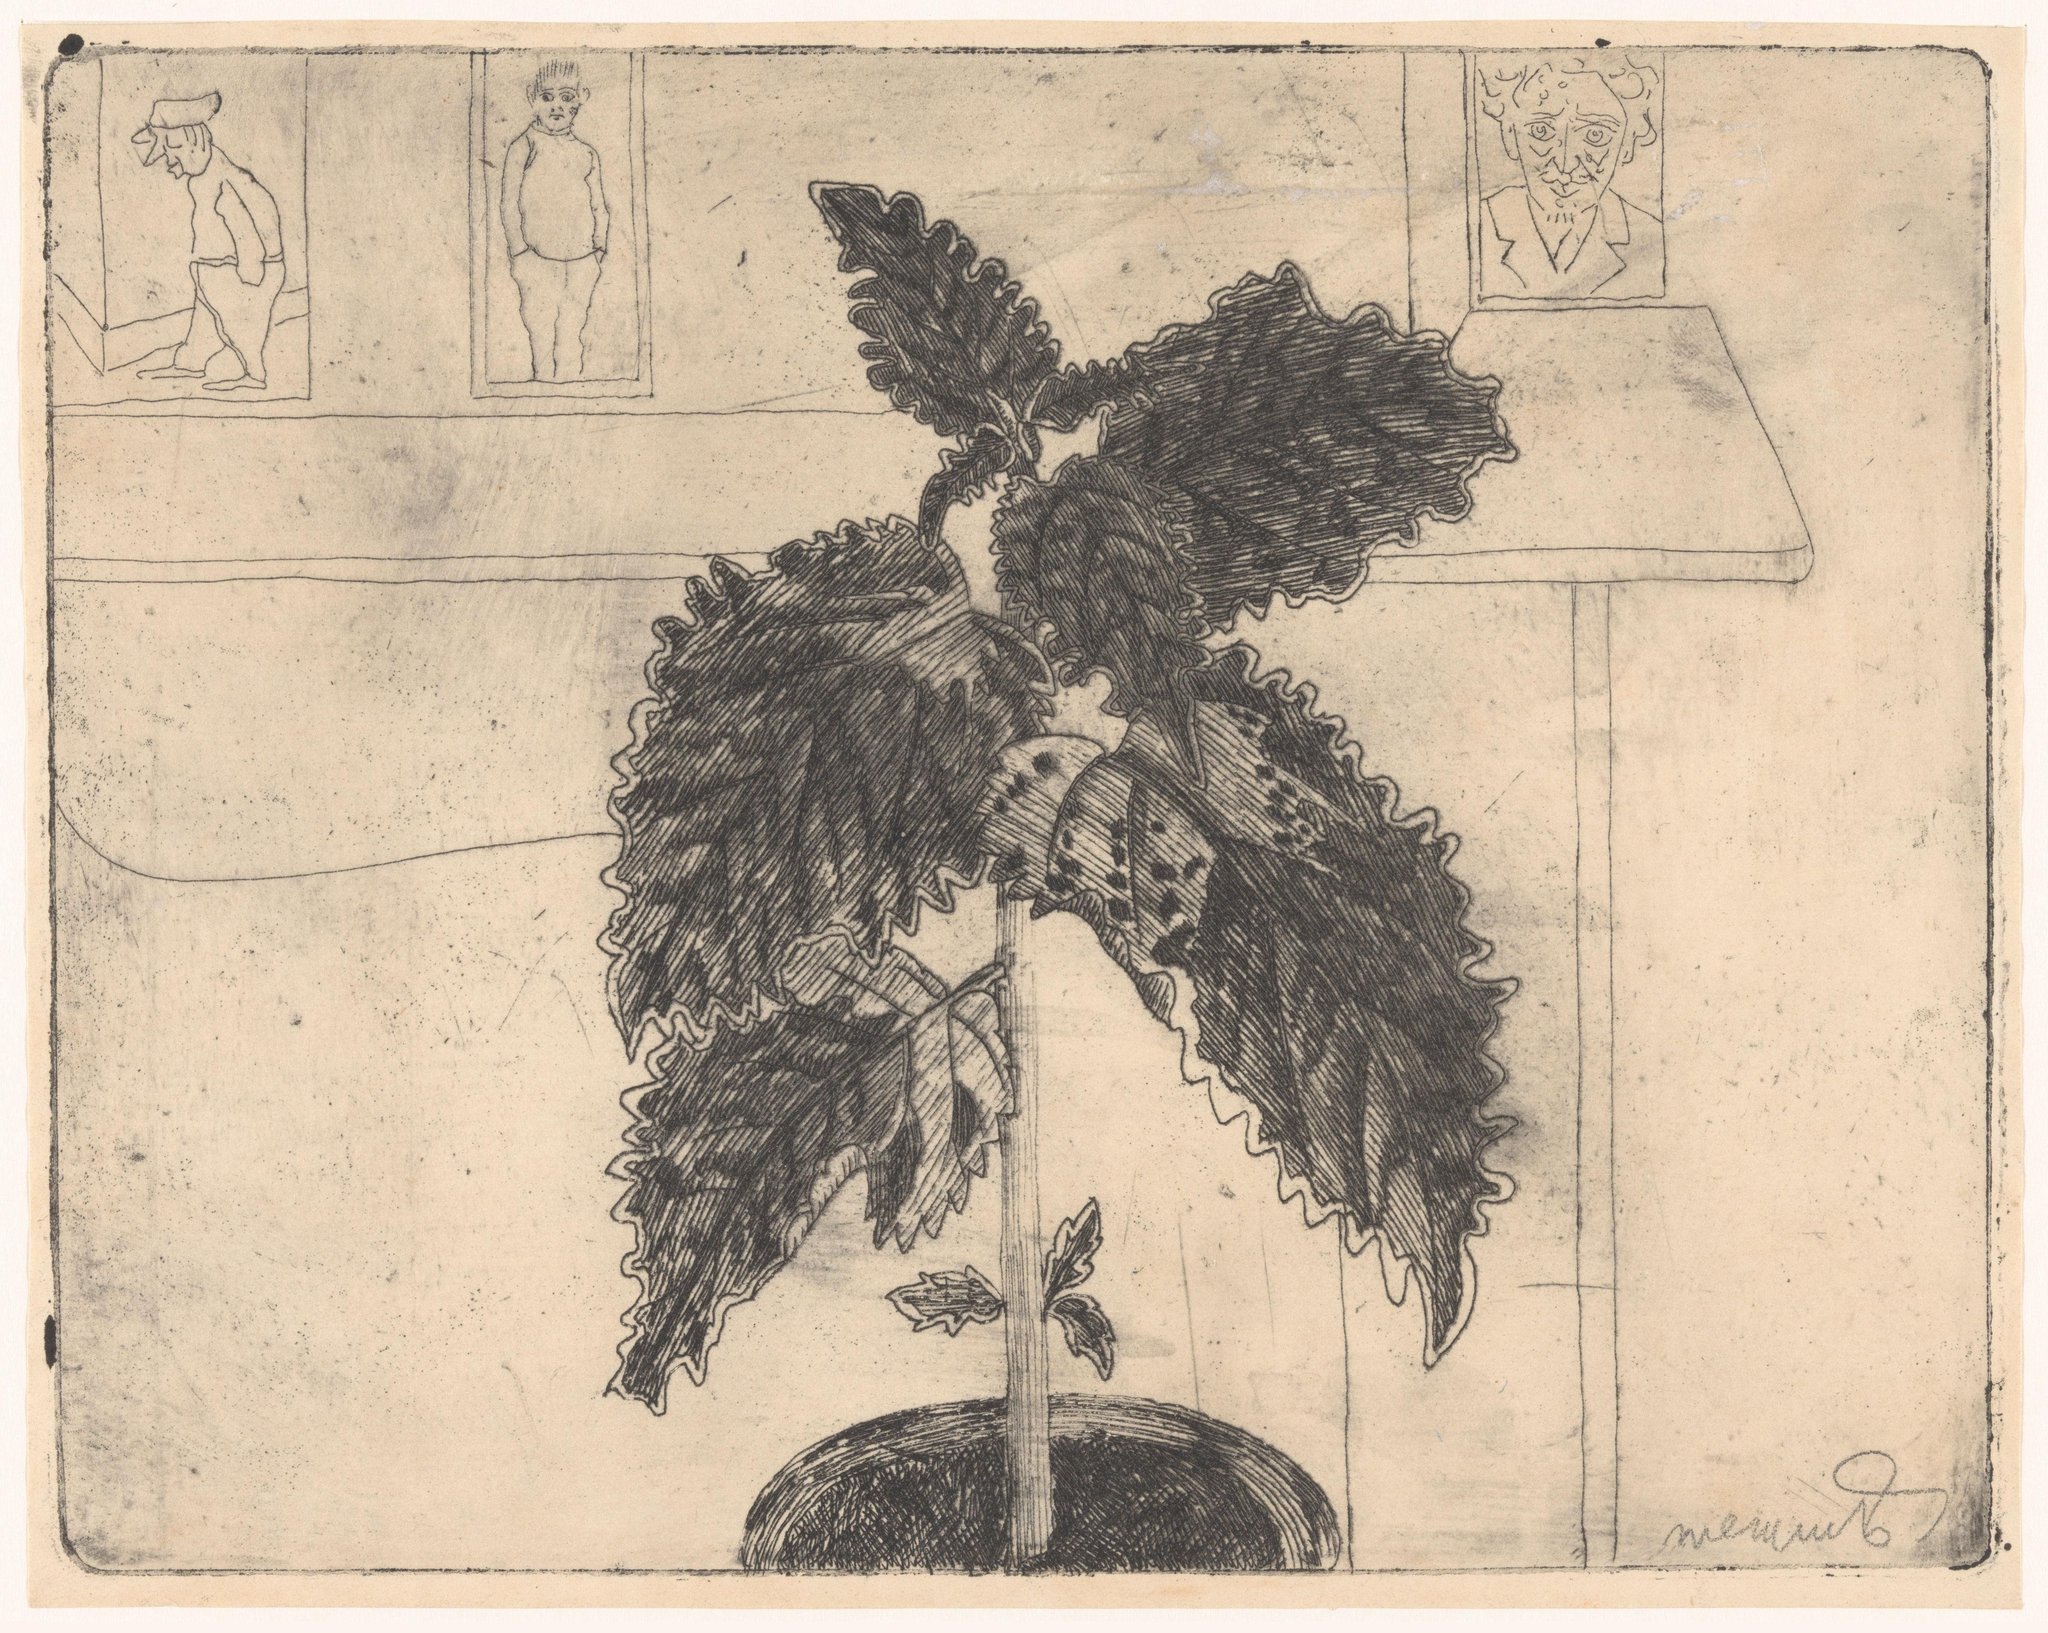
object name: print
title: Sierbrandnetel voor schoorsteenmantel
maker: samuel jessurun de mesquita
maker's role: draughtsman, print maker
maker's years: 1868-1944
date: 1911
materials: paper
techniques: etching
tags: picture within picture, chimney-piece, mantelpiece, potted plants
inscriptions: collector's mark: Lugt 2228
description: Op de schoorsteenmantel staan drie kunstwerken.